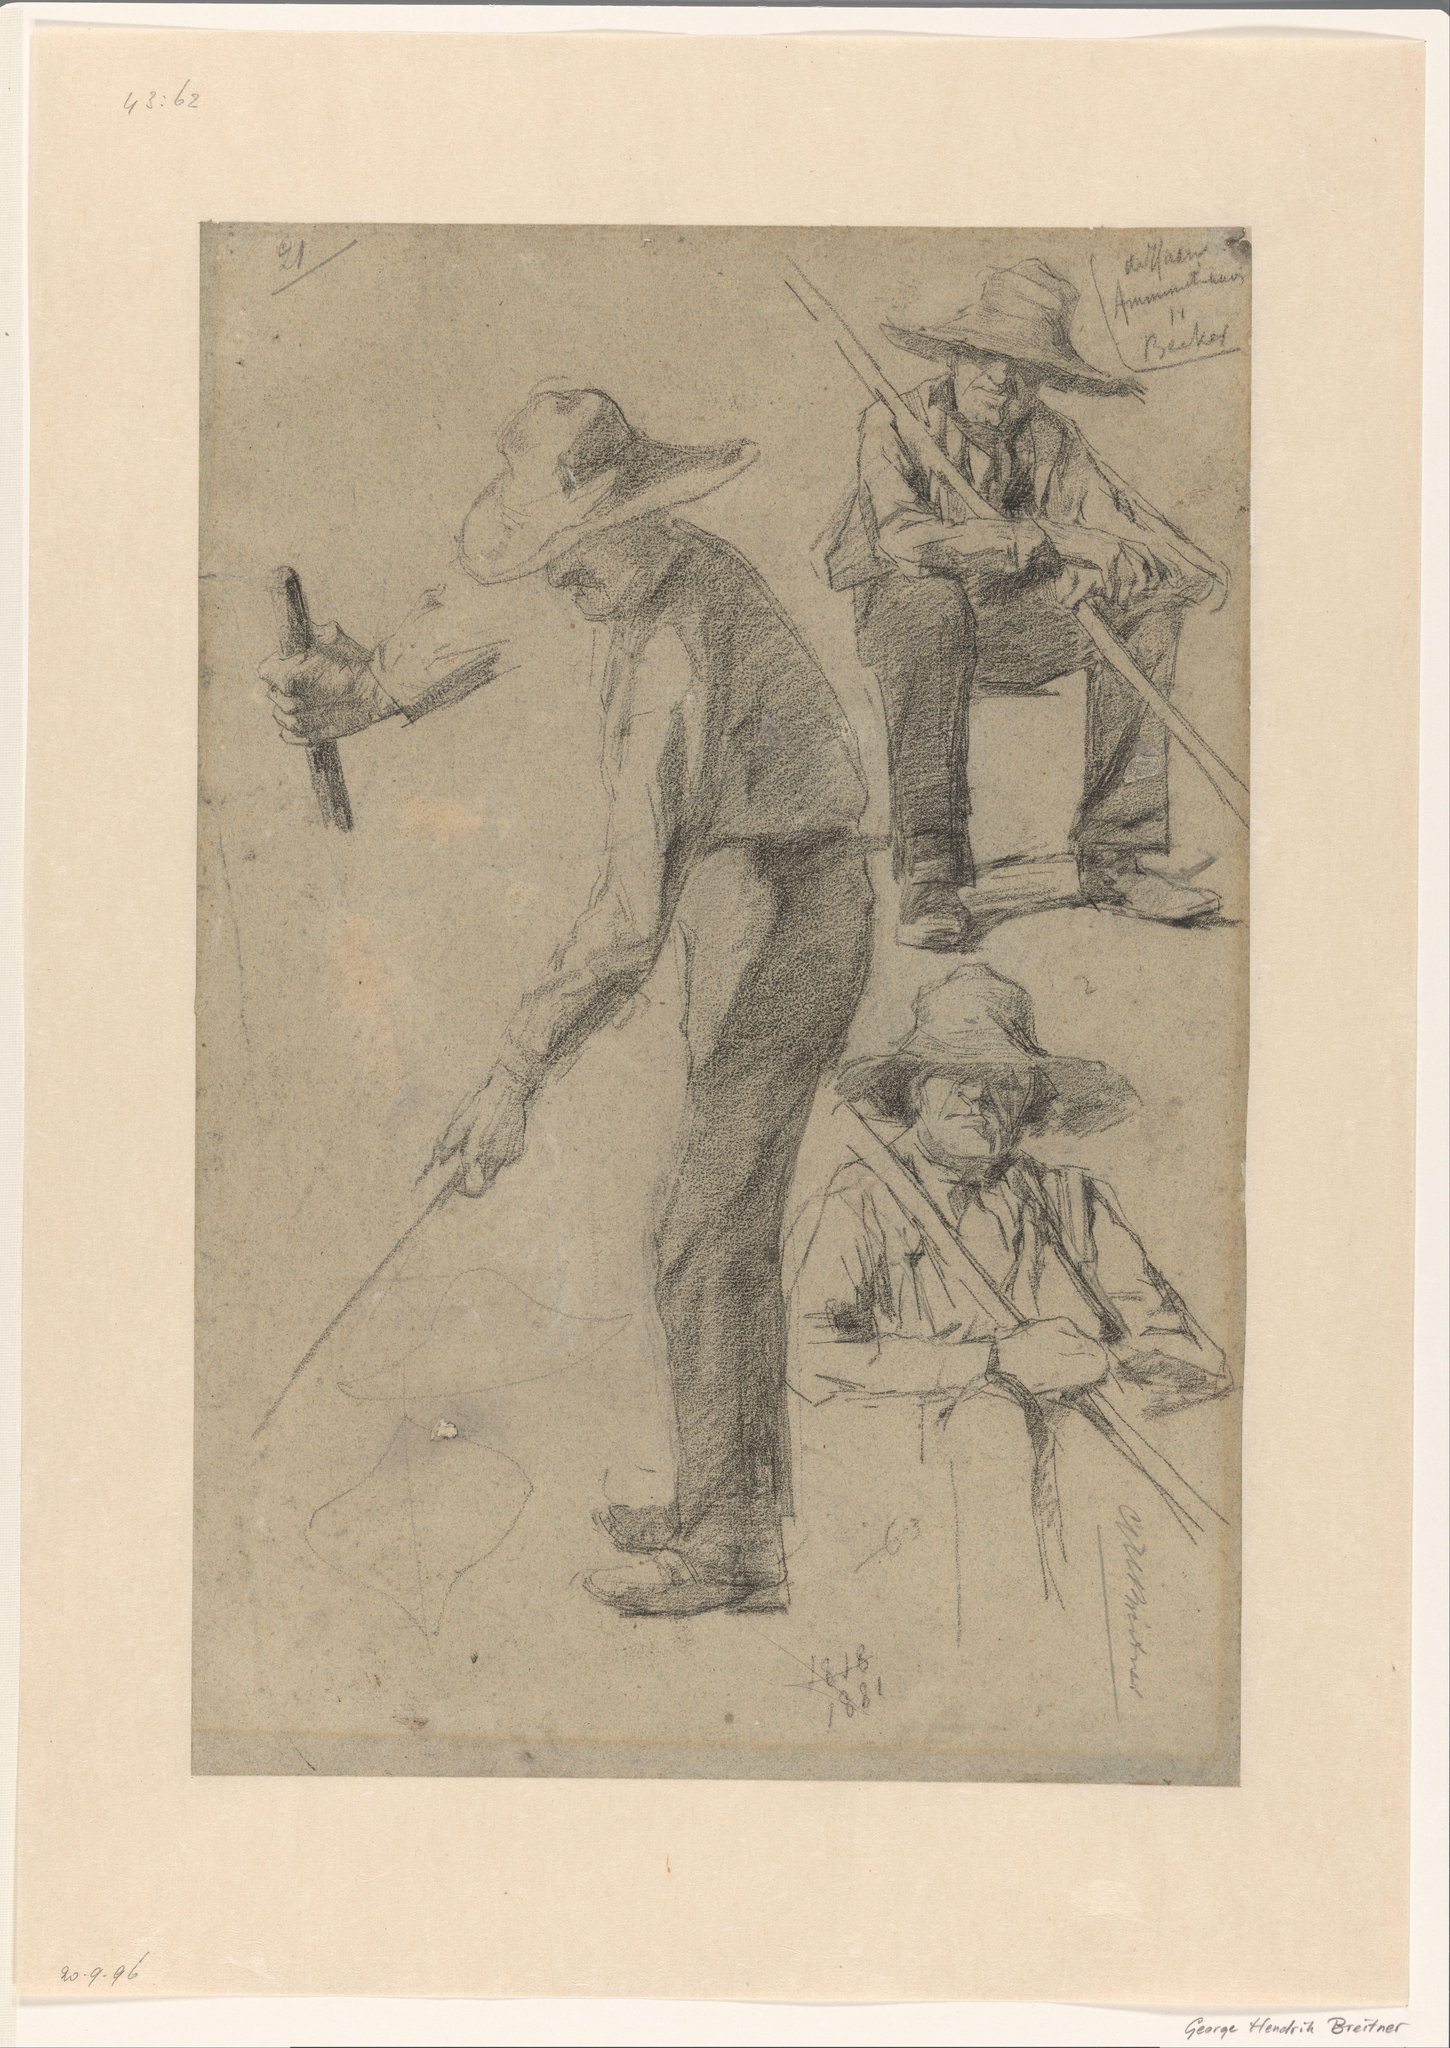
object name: drawing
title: Schetsblad met studies van een tuinman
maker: george hendrik breitner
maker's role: draughtsman, painter, print maker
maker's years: 1857-1923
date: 1867-1923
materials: chalk, paper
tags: gardening